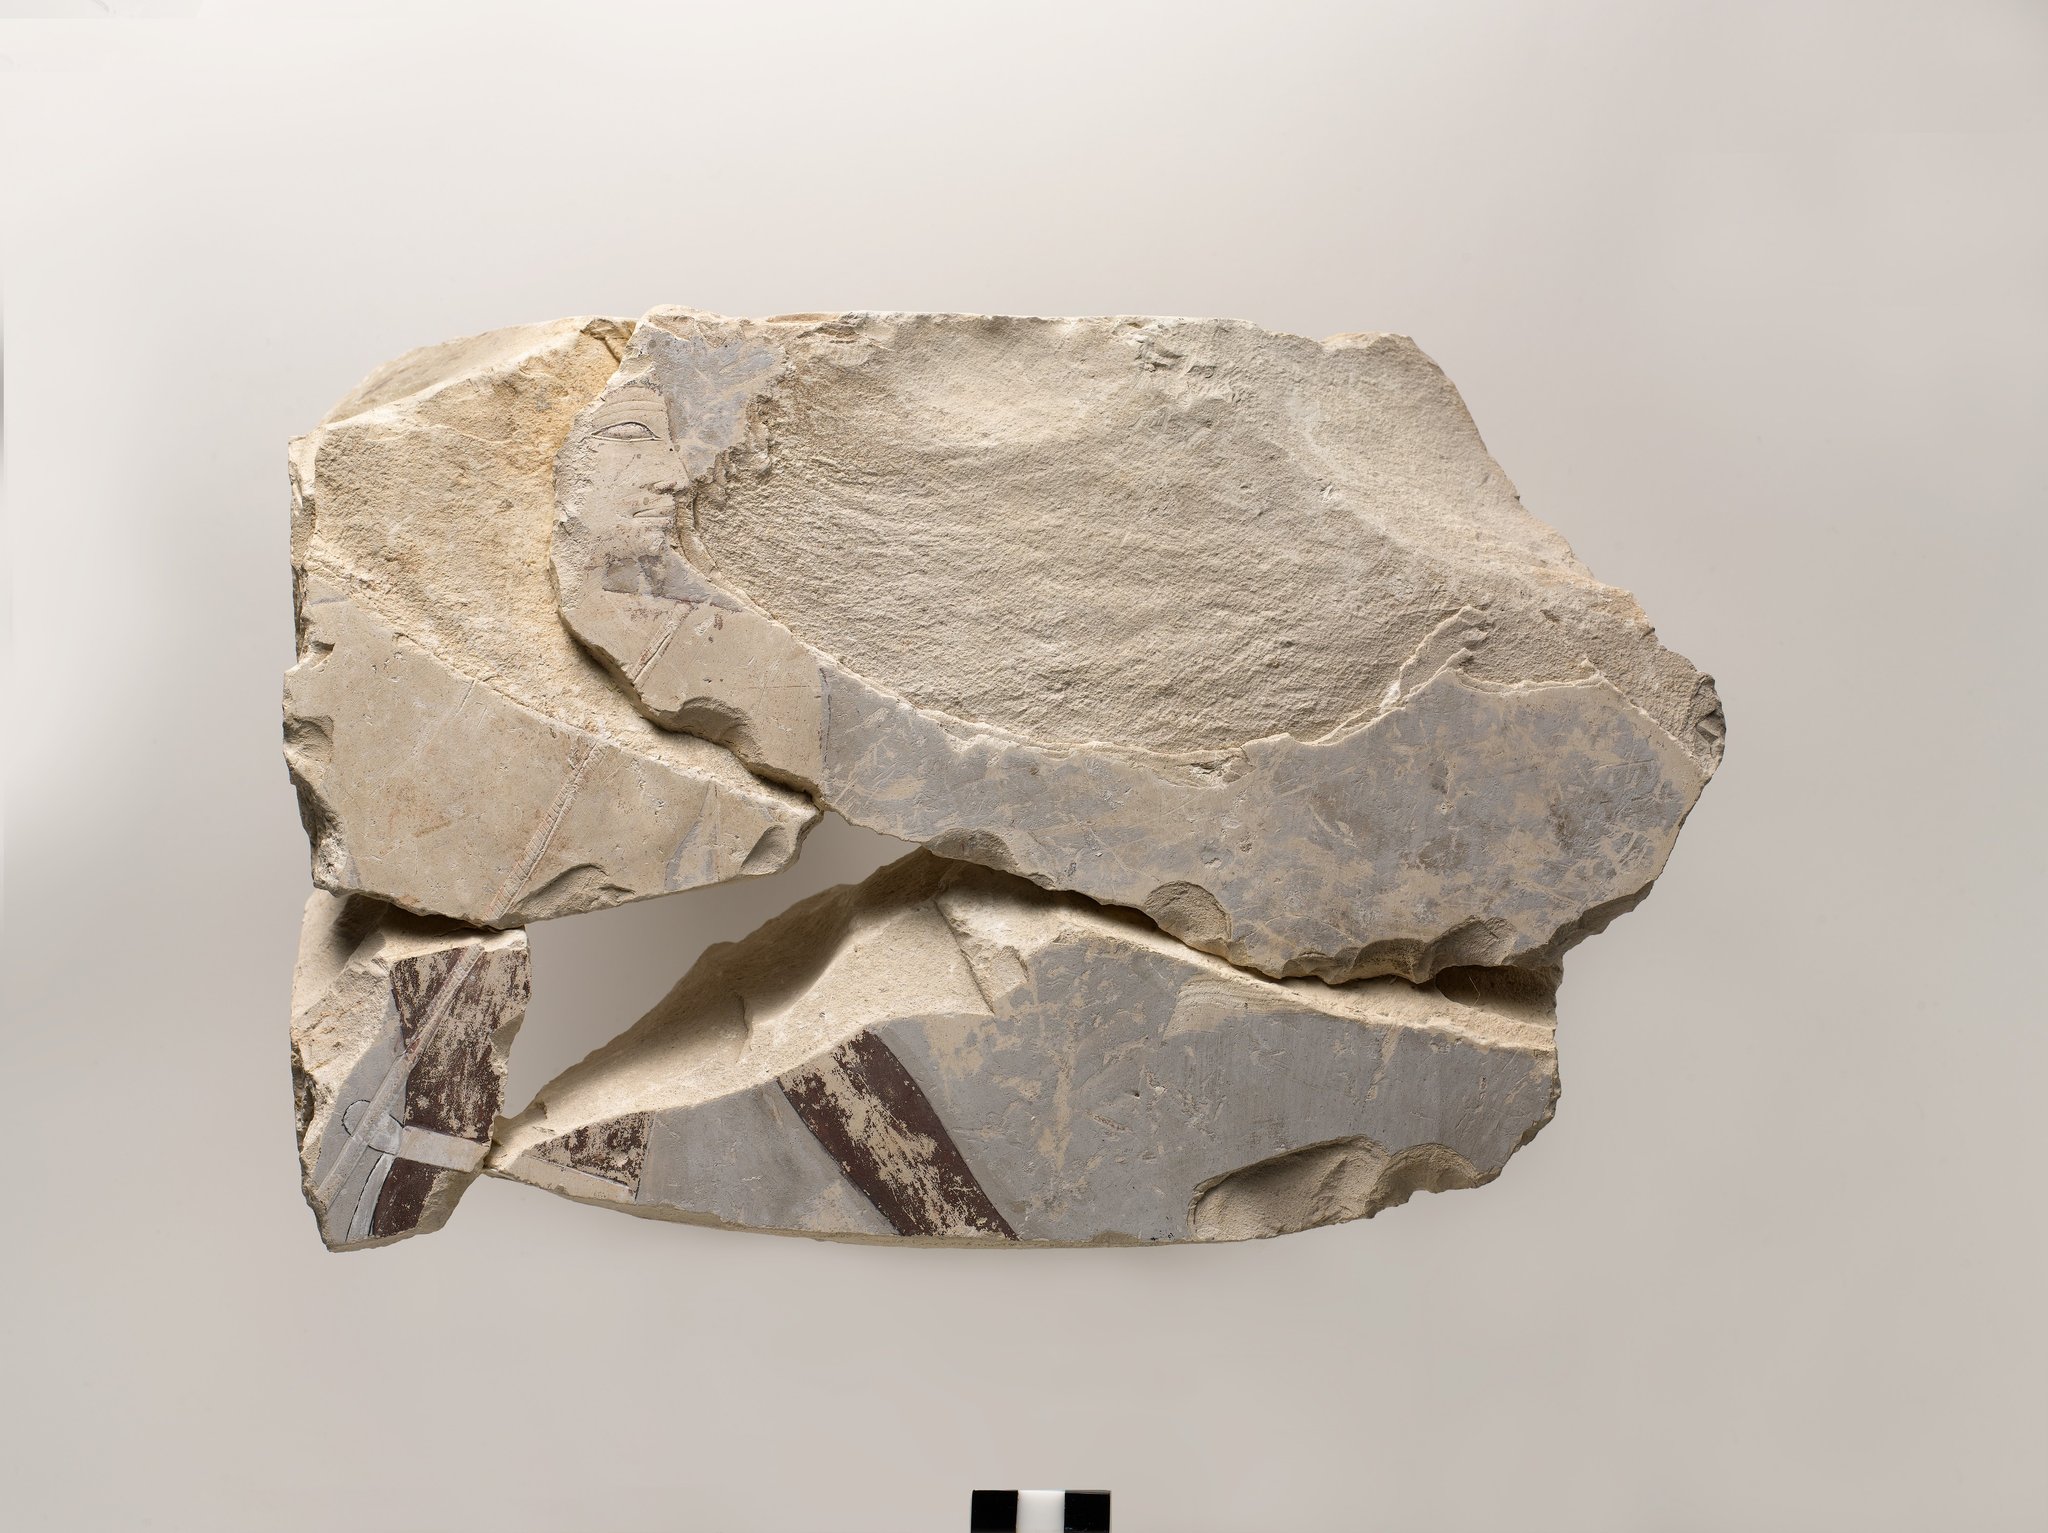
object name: relief fragment, tomb of meketre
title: Relief fragments from the tomb of Meketre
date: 1981-1975 BCE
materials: limestone, paint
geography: egypt